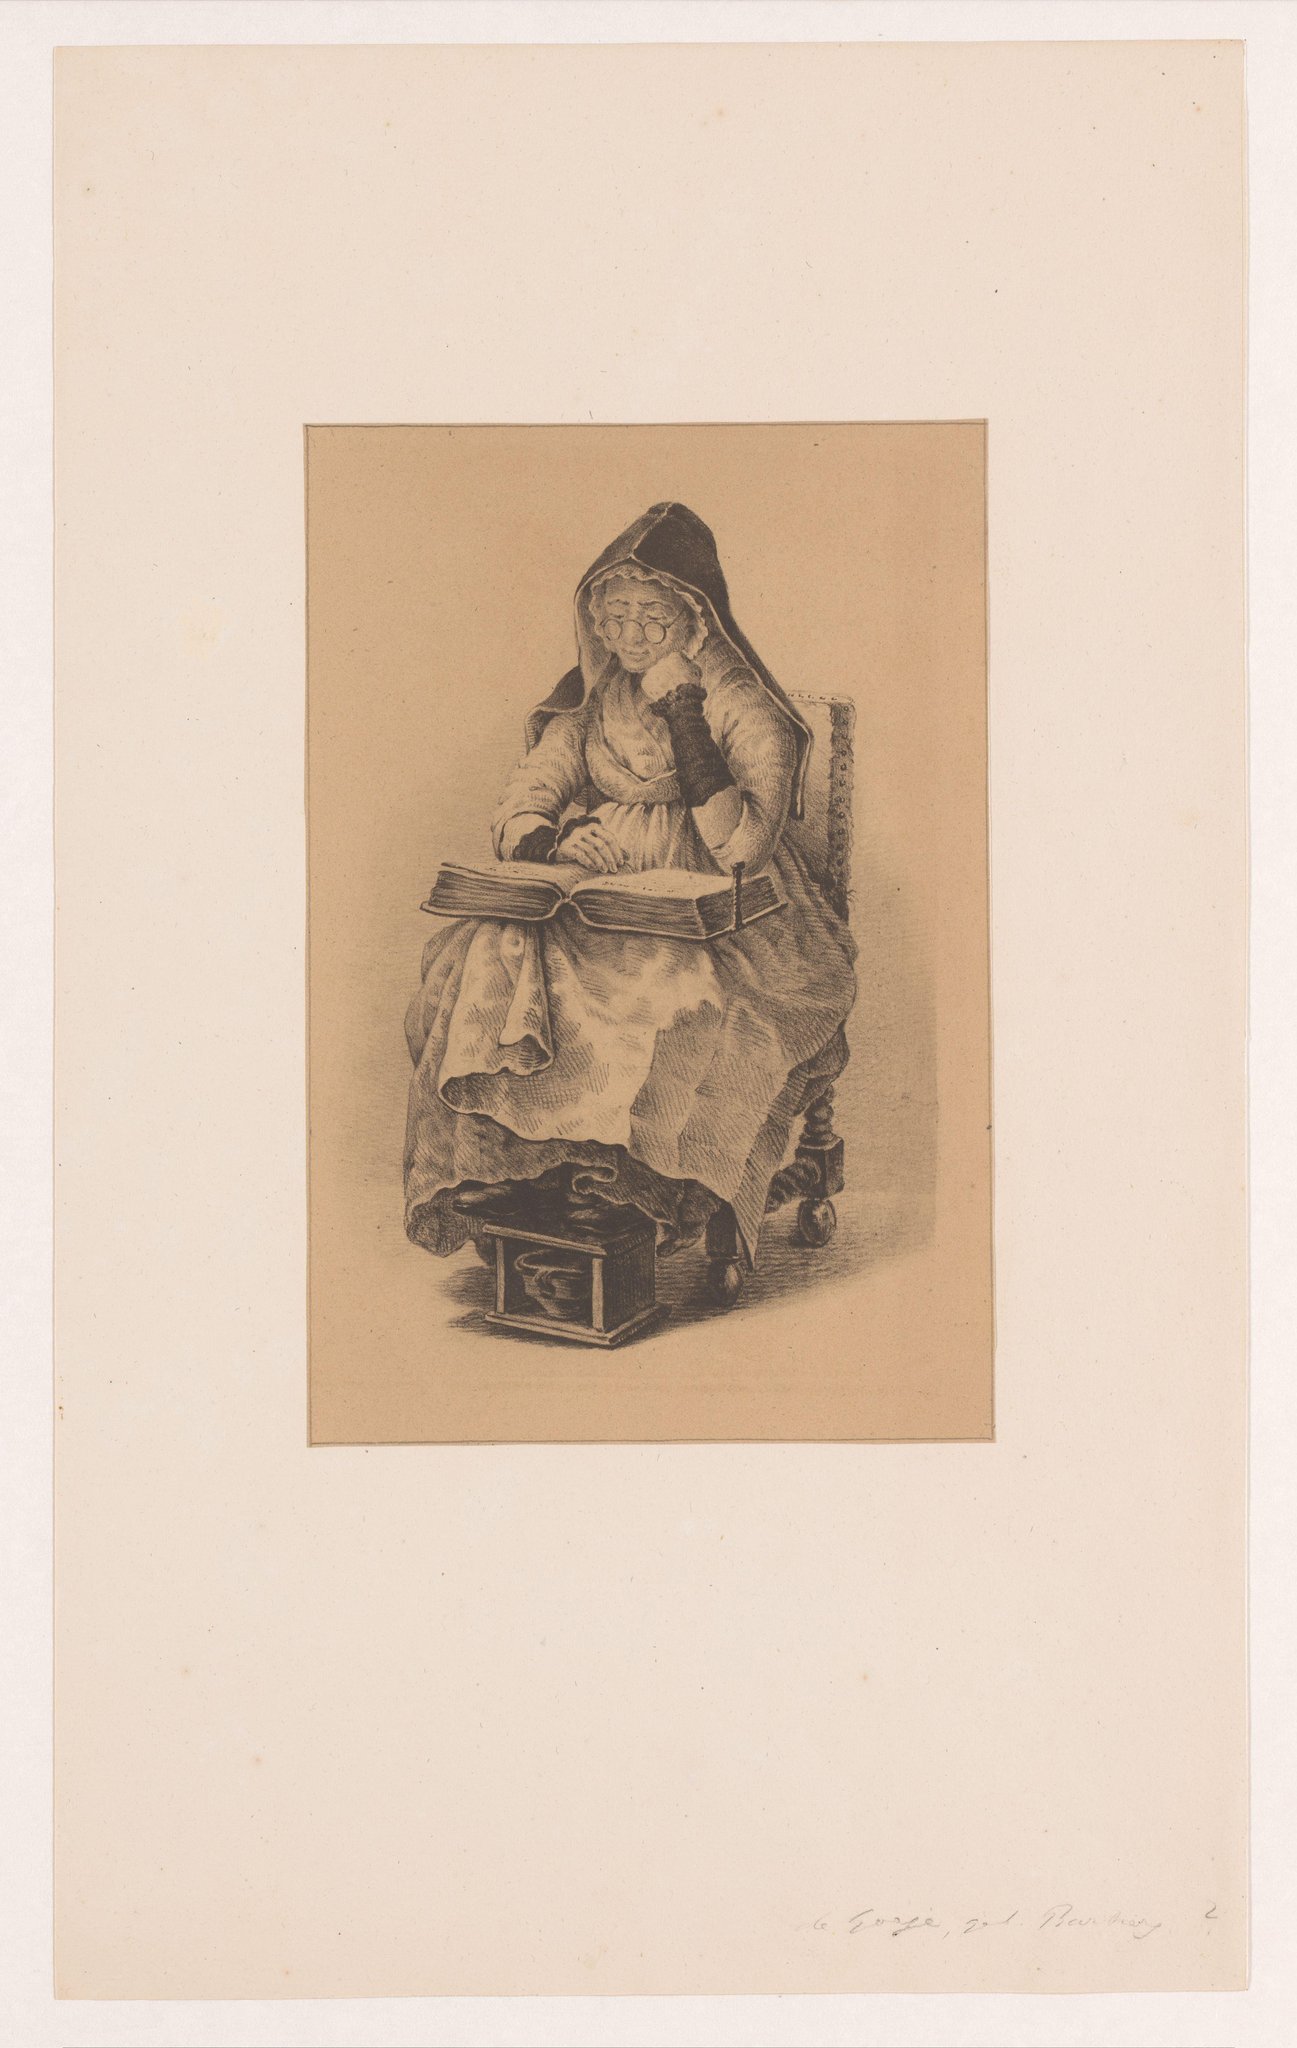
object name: print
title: Lezende vrouw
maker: pieter de goeje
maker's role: draughtsman, print maker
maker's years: 1789-1859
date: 1809-1859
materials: paper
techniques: lithograph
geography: netherlands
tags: reading, old woman (+ sitting)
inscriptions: inscription: ‘de Goeje, ged. Barbiers ?’, collector's mark: Lugt 2228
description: Ze draagt een kap en een bril, ze rust met haar voeten op een stoof.